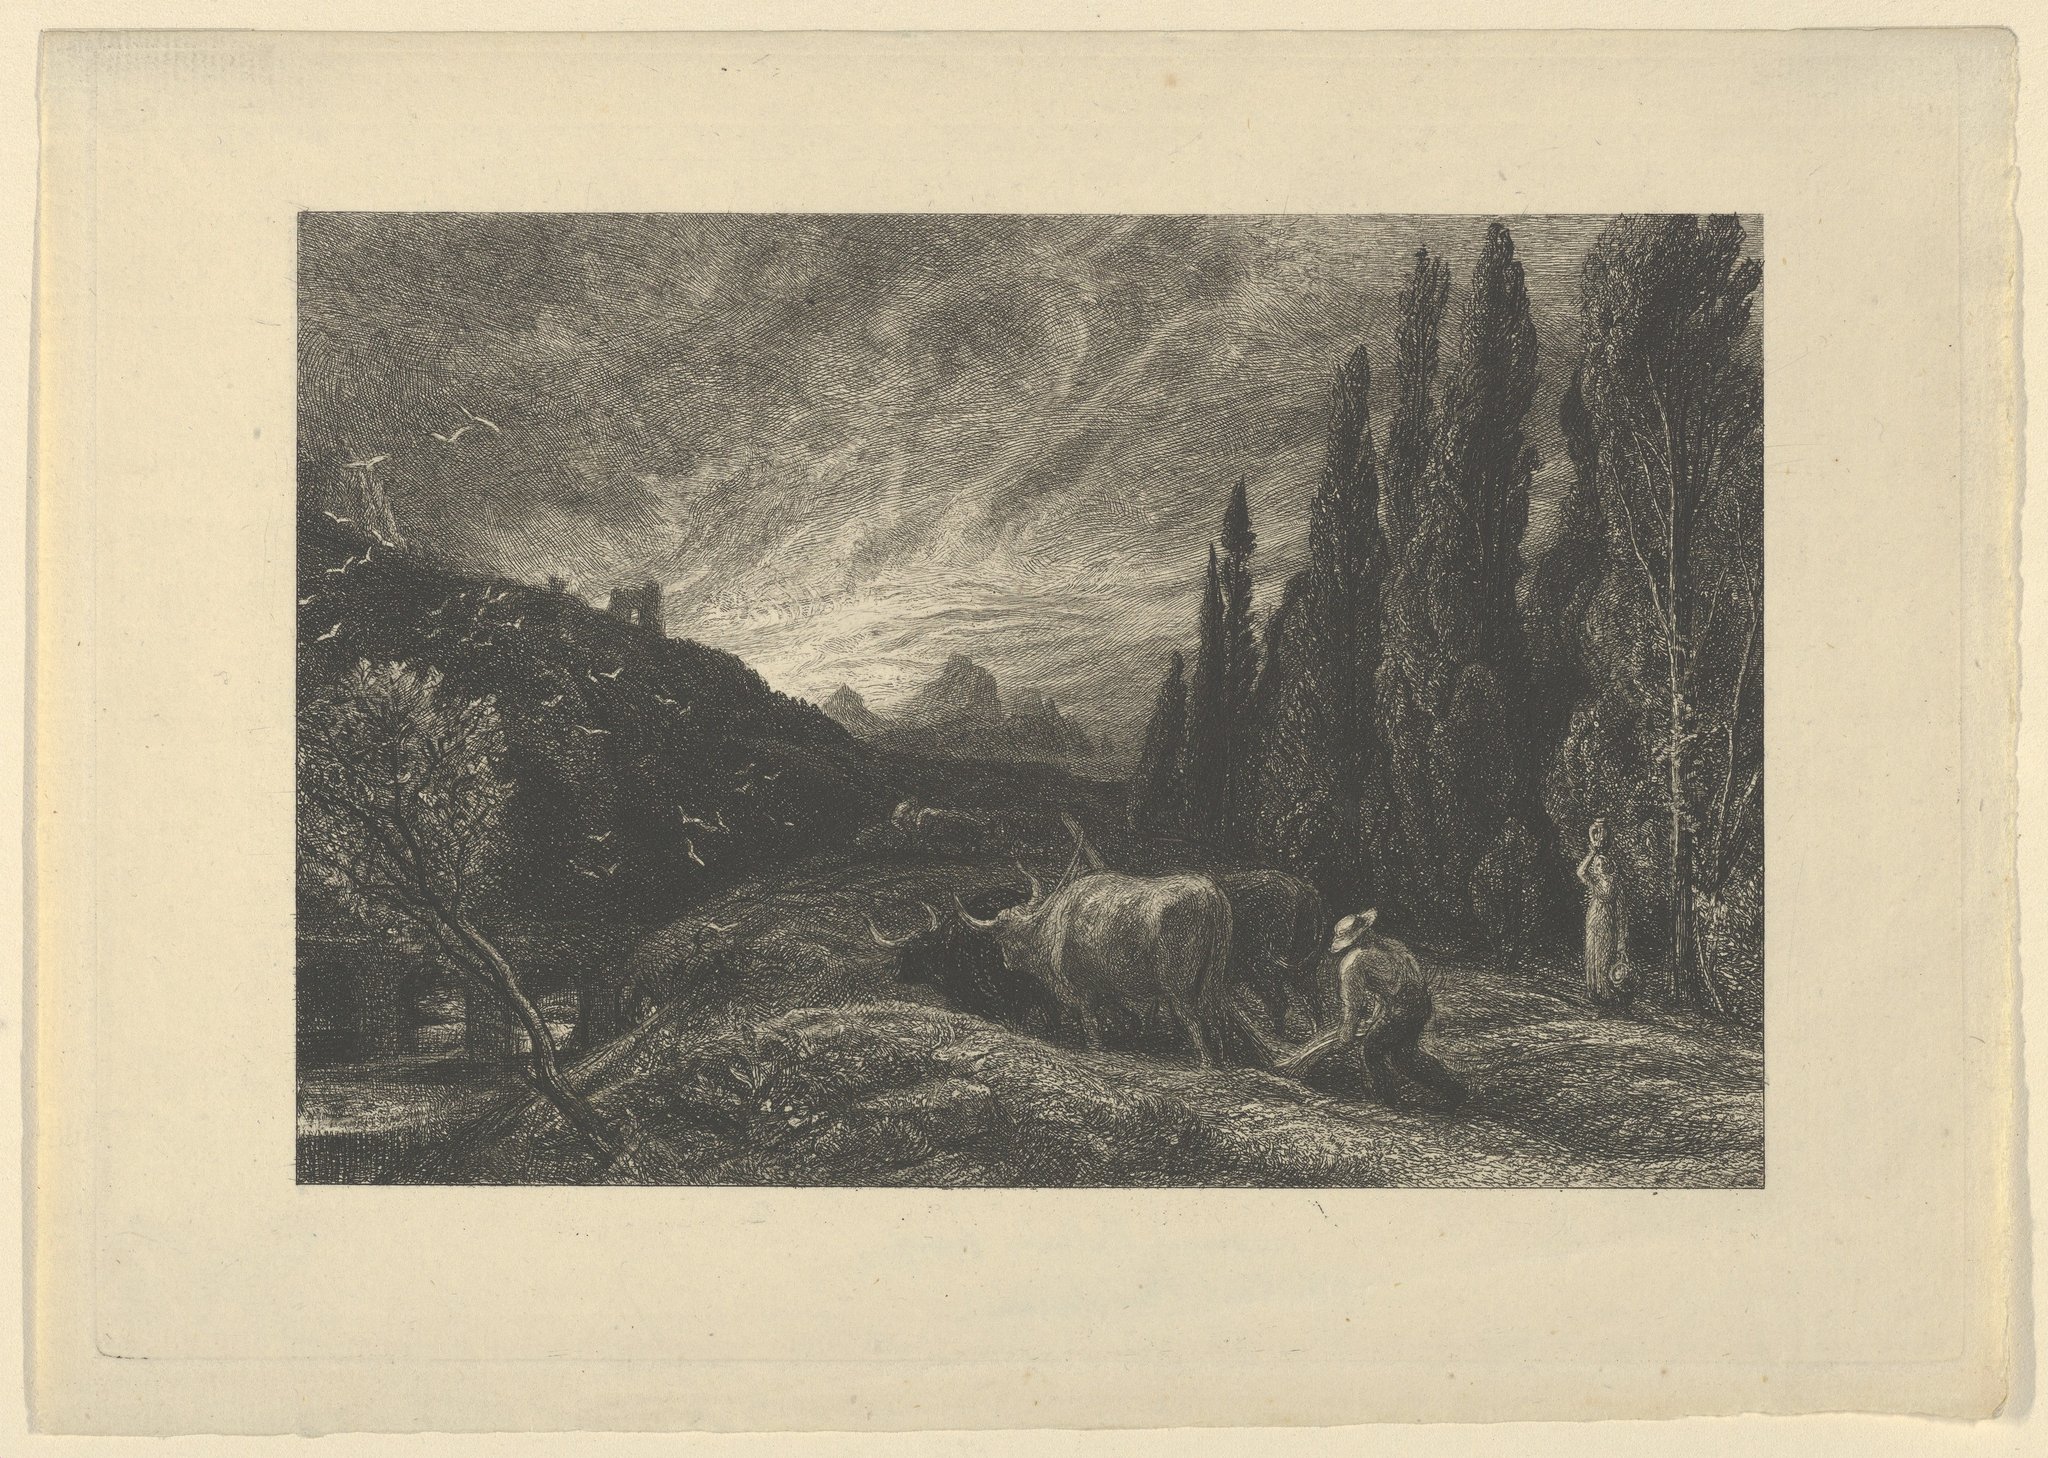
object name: print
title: The Early Ploughman, or The Morning Spread Upon the Mountains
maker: samuel palmer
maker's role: artist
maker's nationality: british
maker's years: 1805-1881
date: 1861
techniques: etching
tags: animals,men,mountains,trees,working